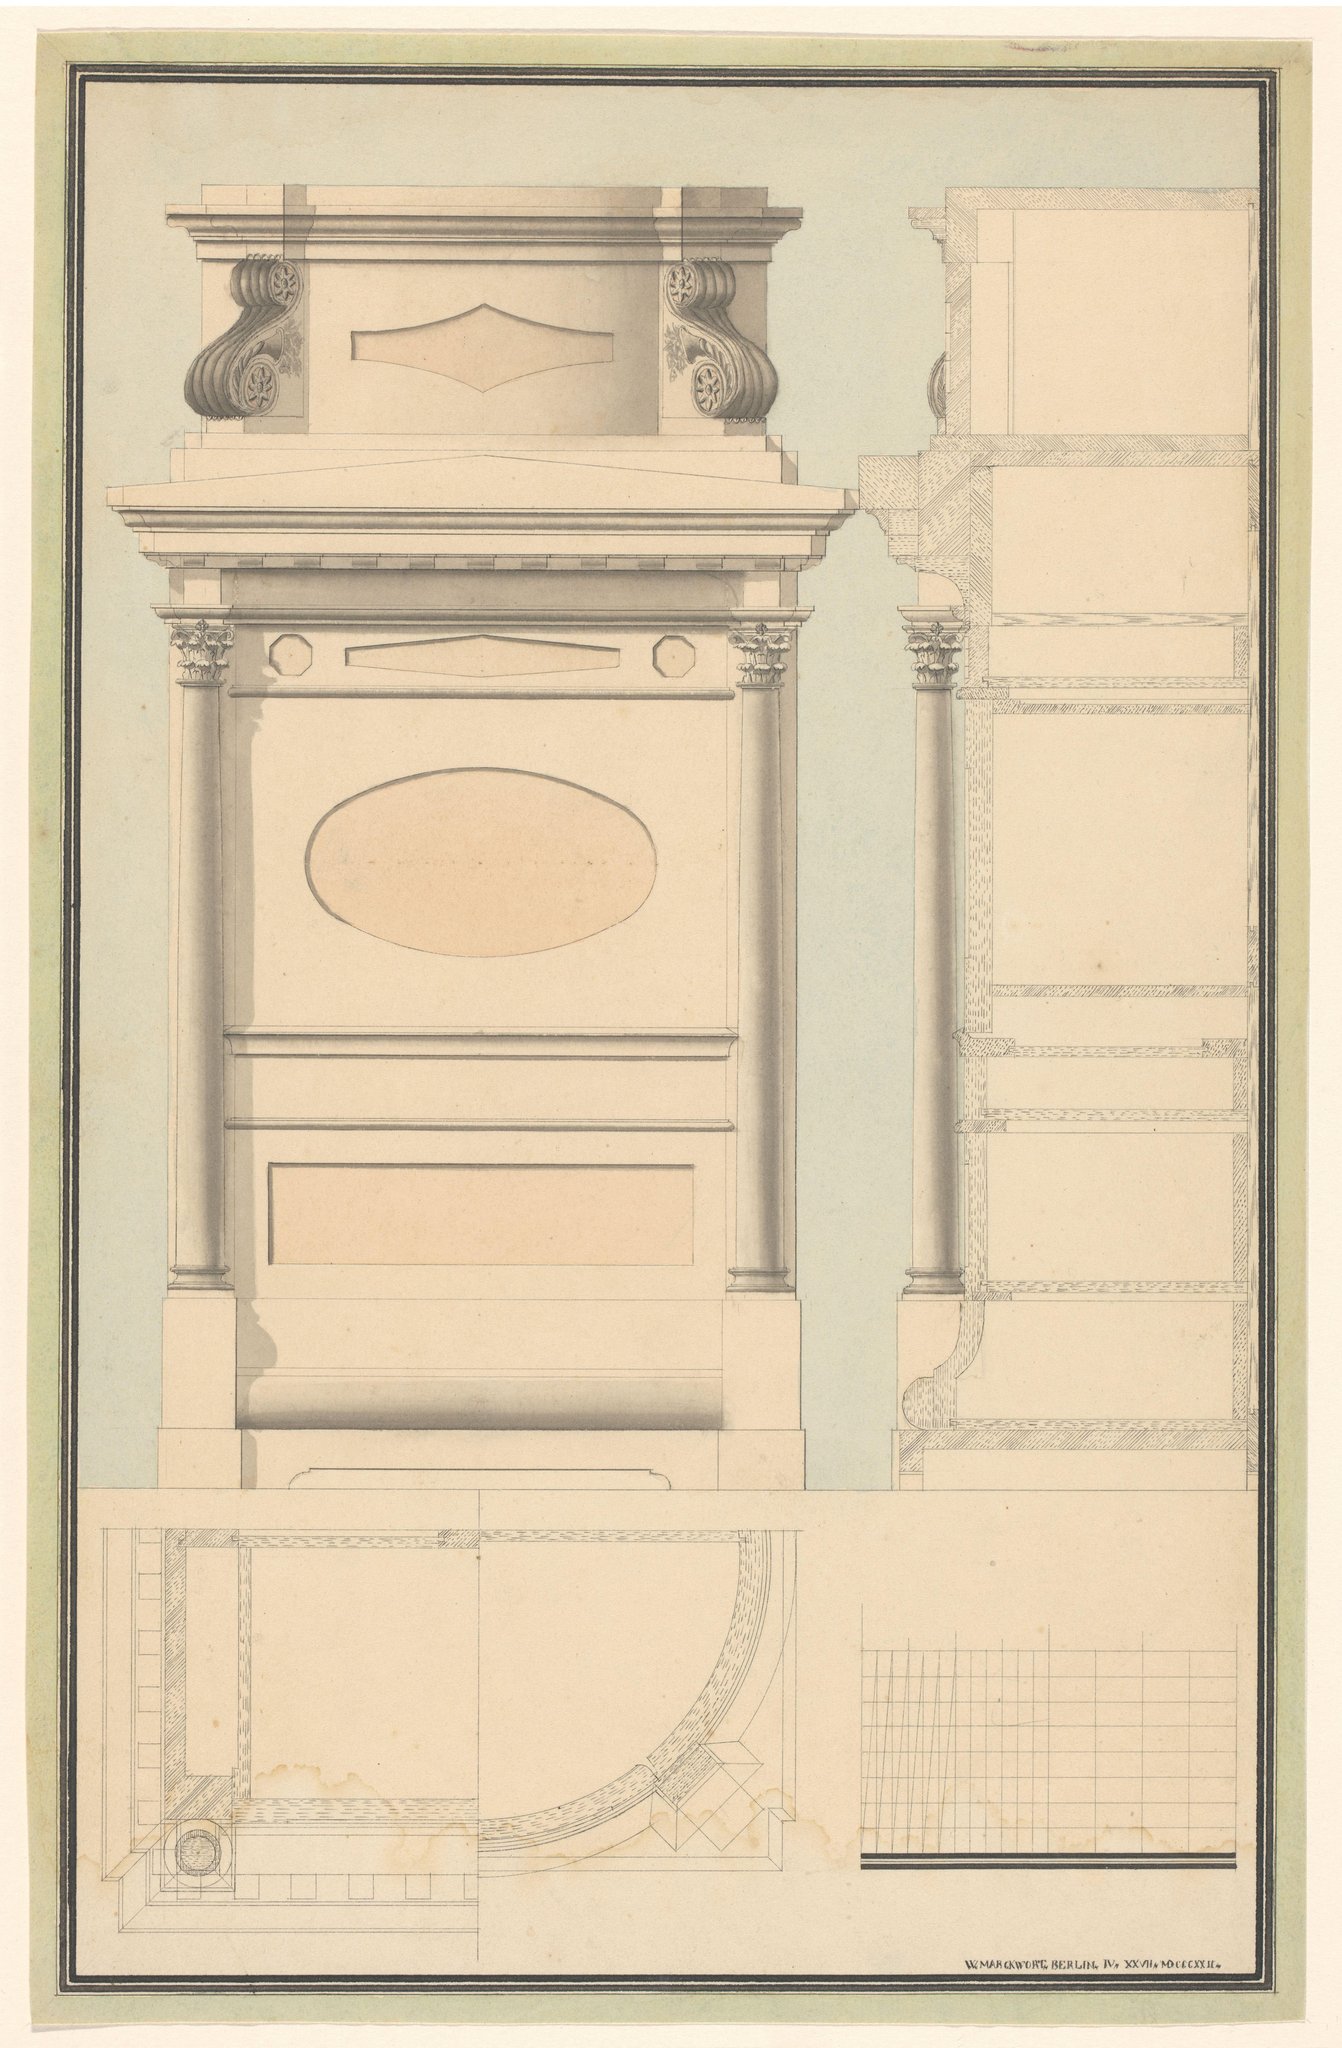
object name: design drawing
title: Ontwerp voor een secretaire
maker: carl wilhelm marckwort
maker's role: draughtsman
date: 1822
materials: ink, paper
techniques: brush, pen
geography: berlin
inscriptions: signature and date: ‘W. MARCKWORT. BERLIN. IV. XXVII. MDCCCXXII.’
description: In de bovenkast twee voluten, in 1821 gemaakt door Joseph Oberfranke. Voor- en zijaanzicht, met daaronder een in tweeën gedeelde plattegrond en een maatverdeling.